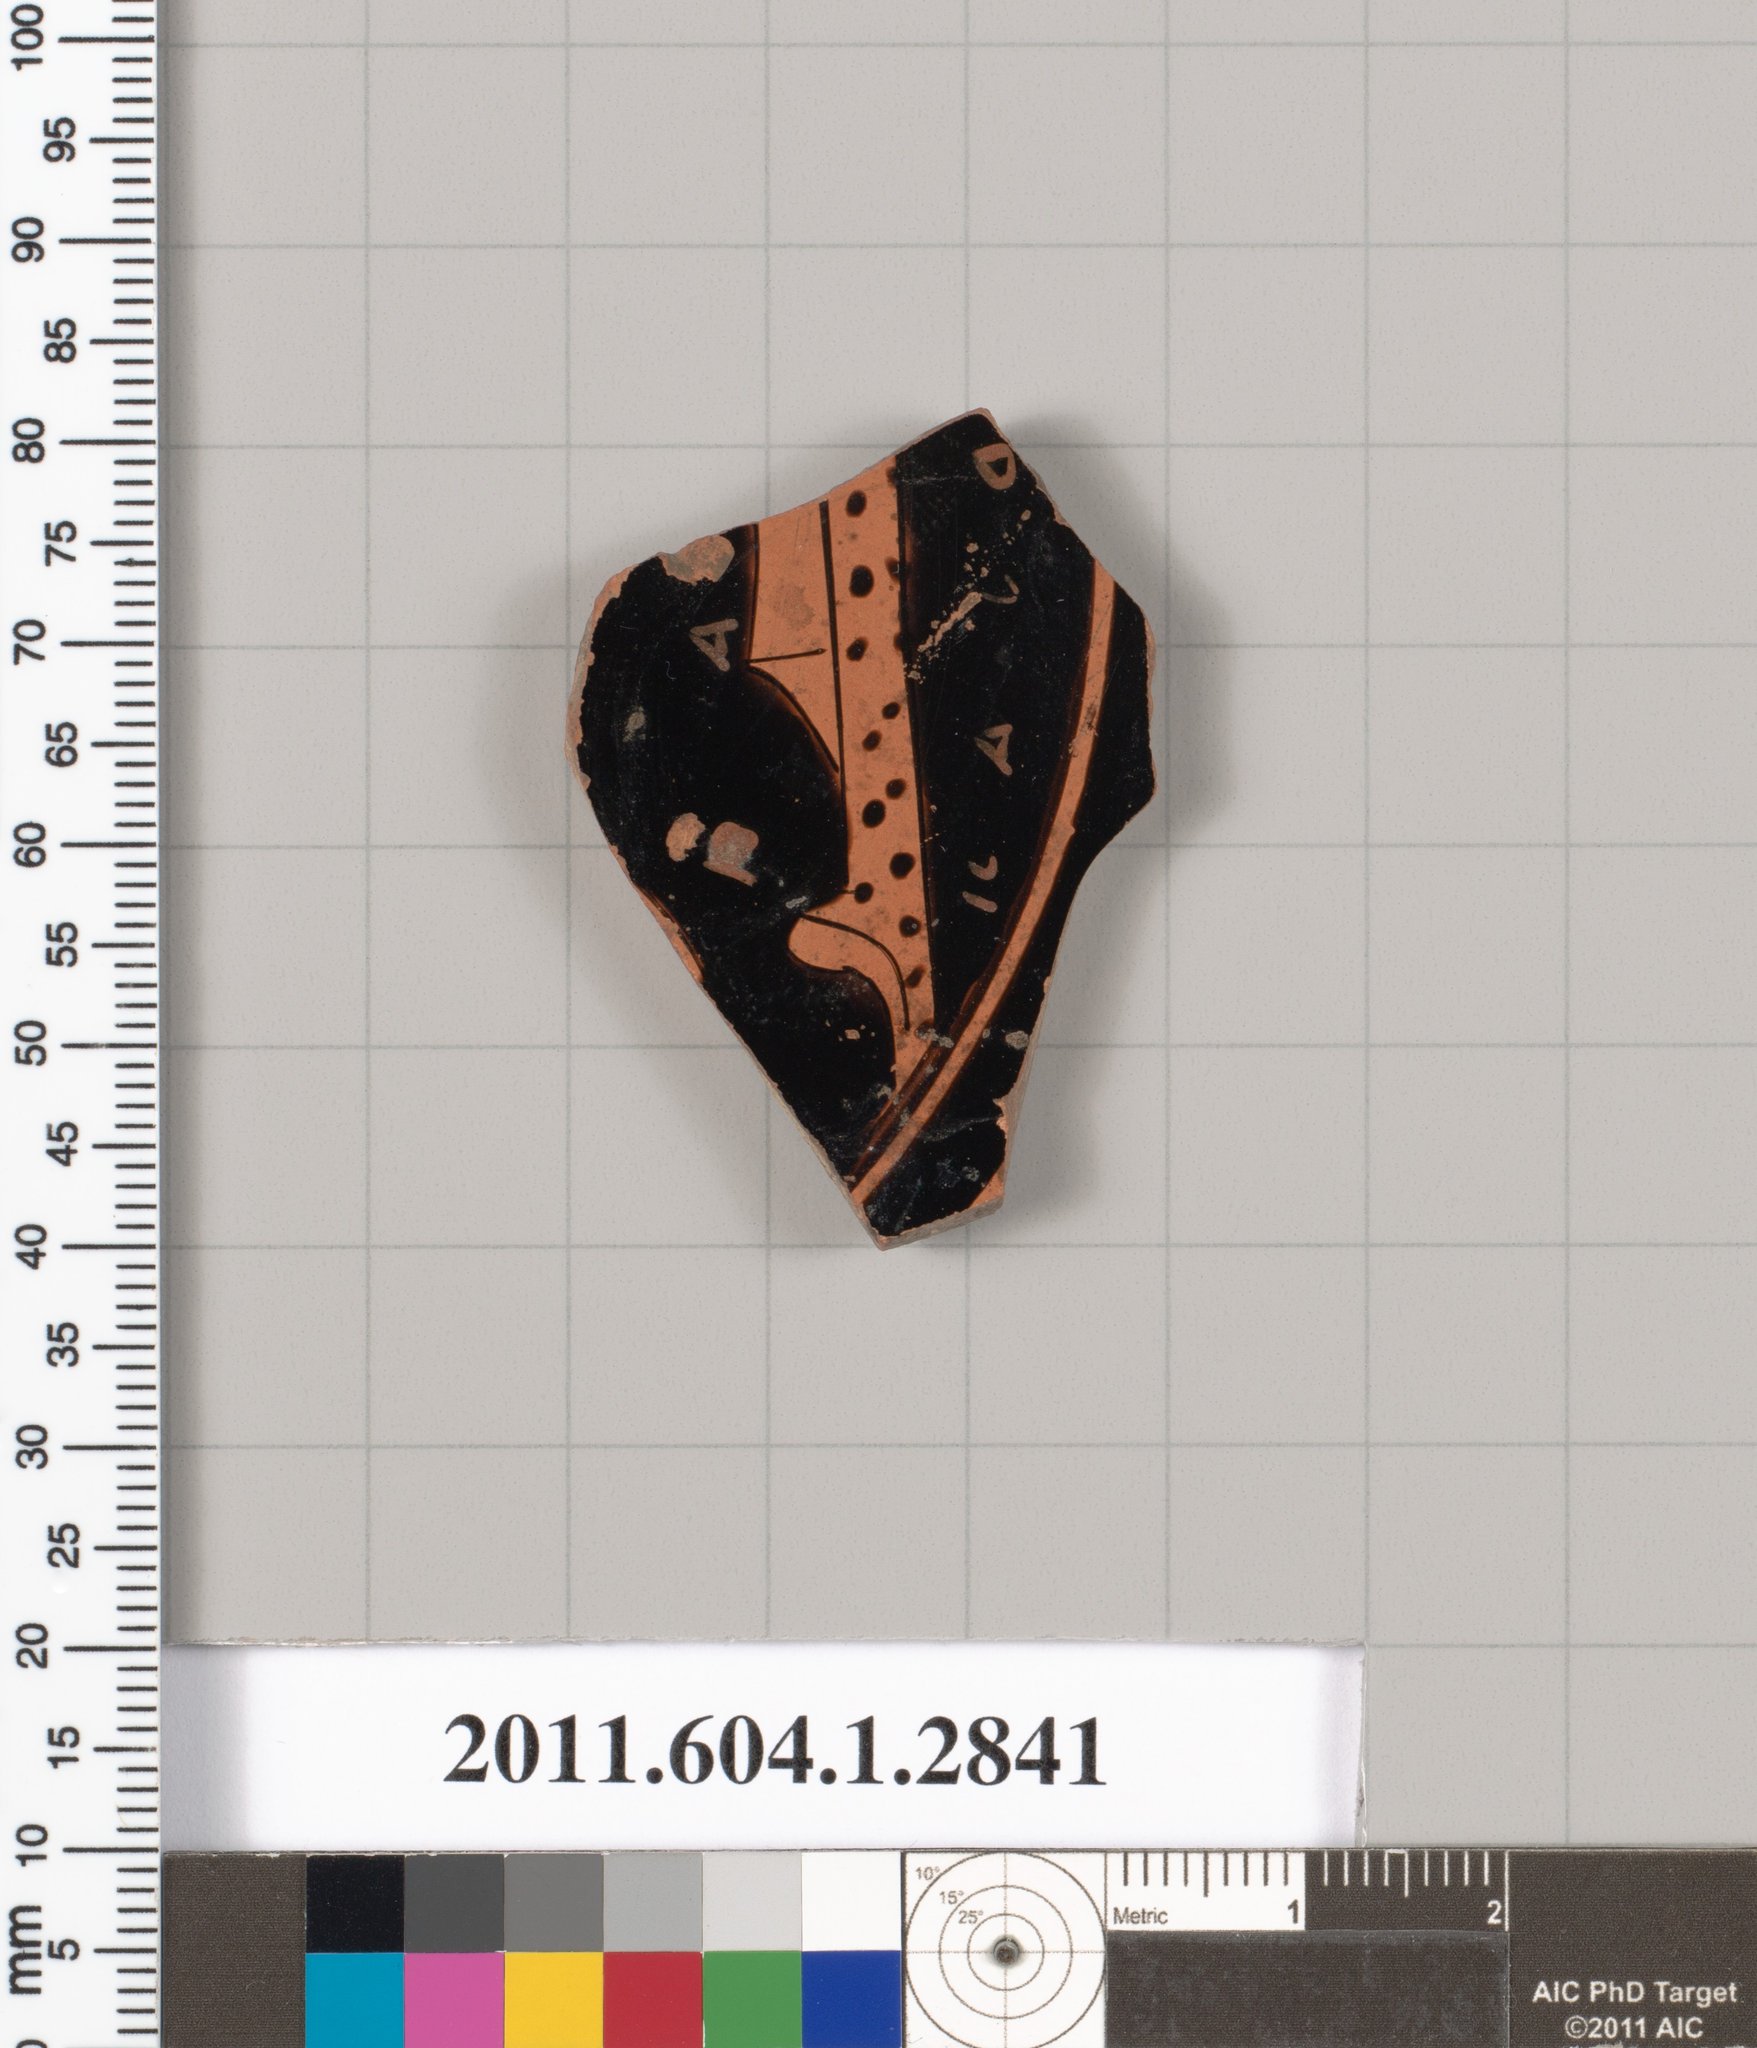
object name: kylix fragment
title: Terracotta fragment of a kylix (drinking cup)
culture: greek, attic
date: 520-500 BCE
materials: terracotta